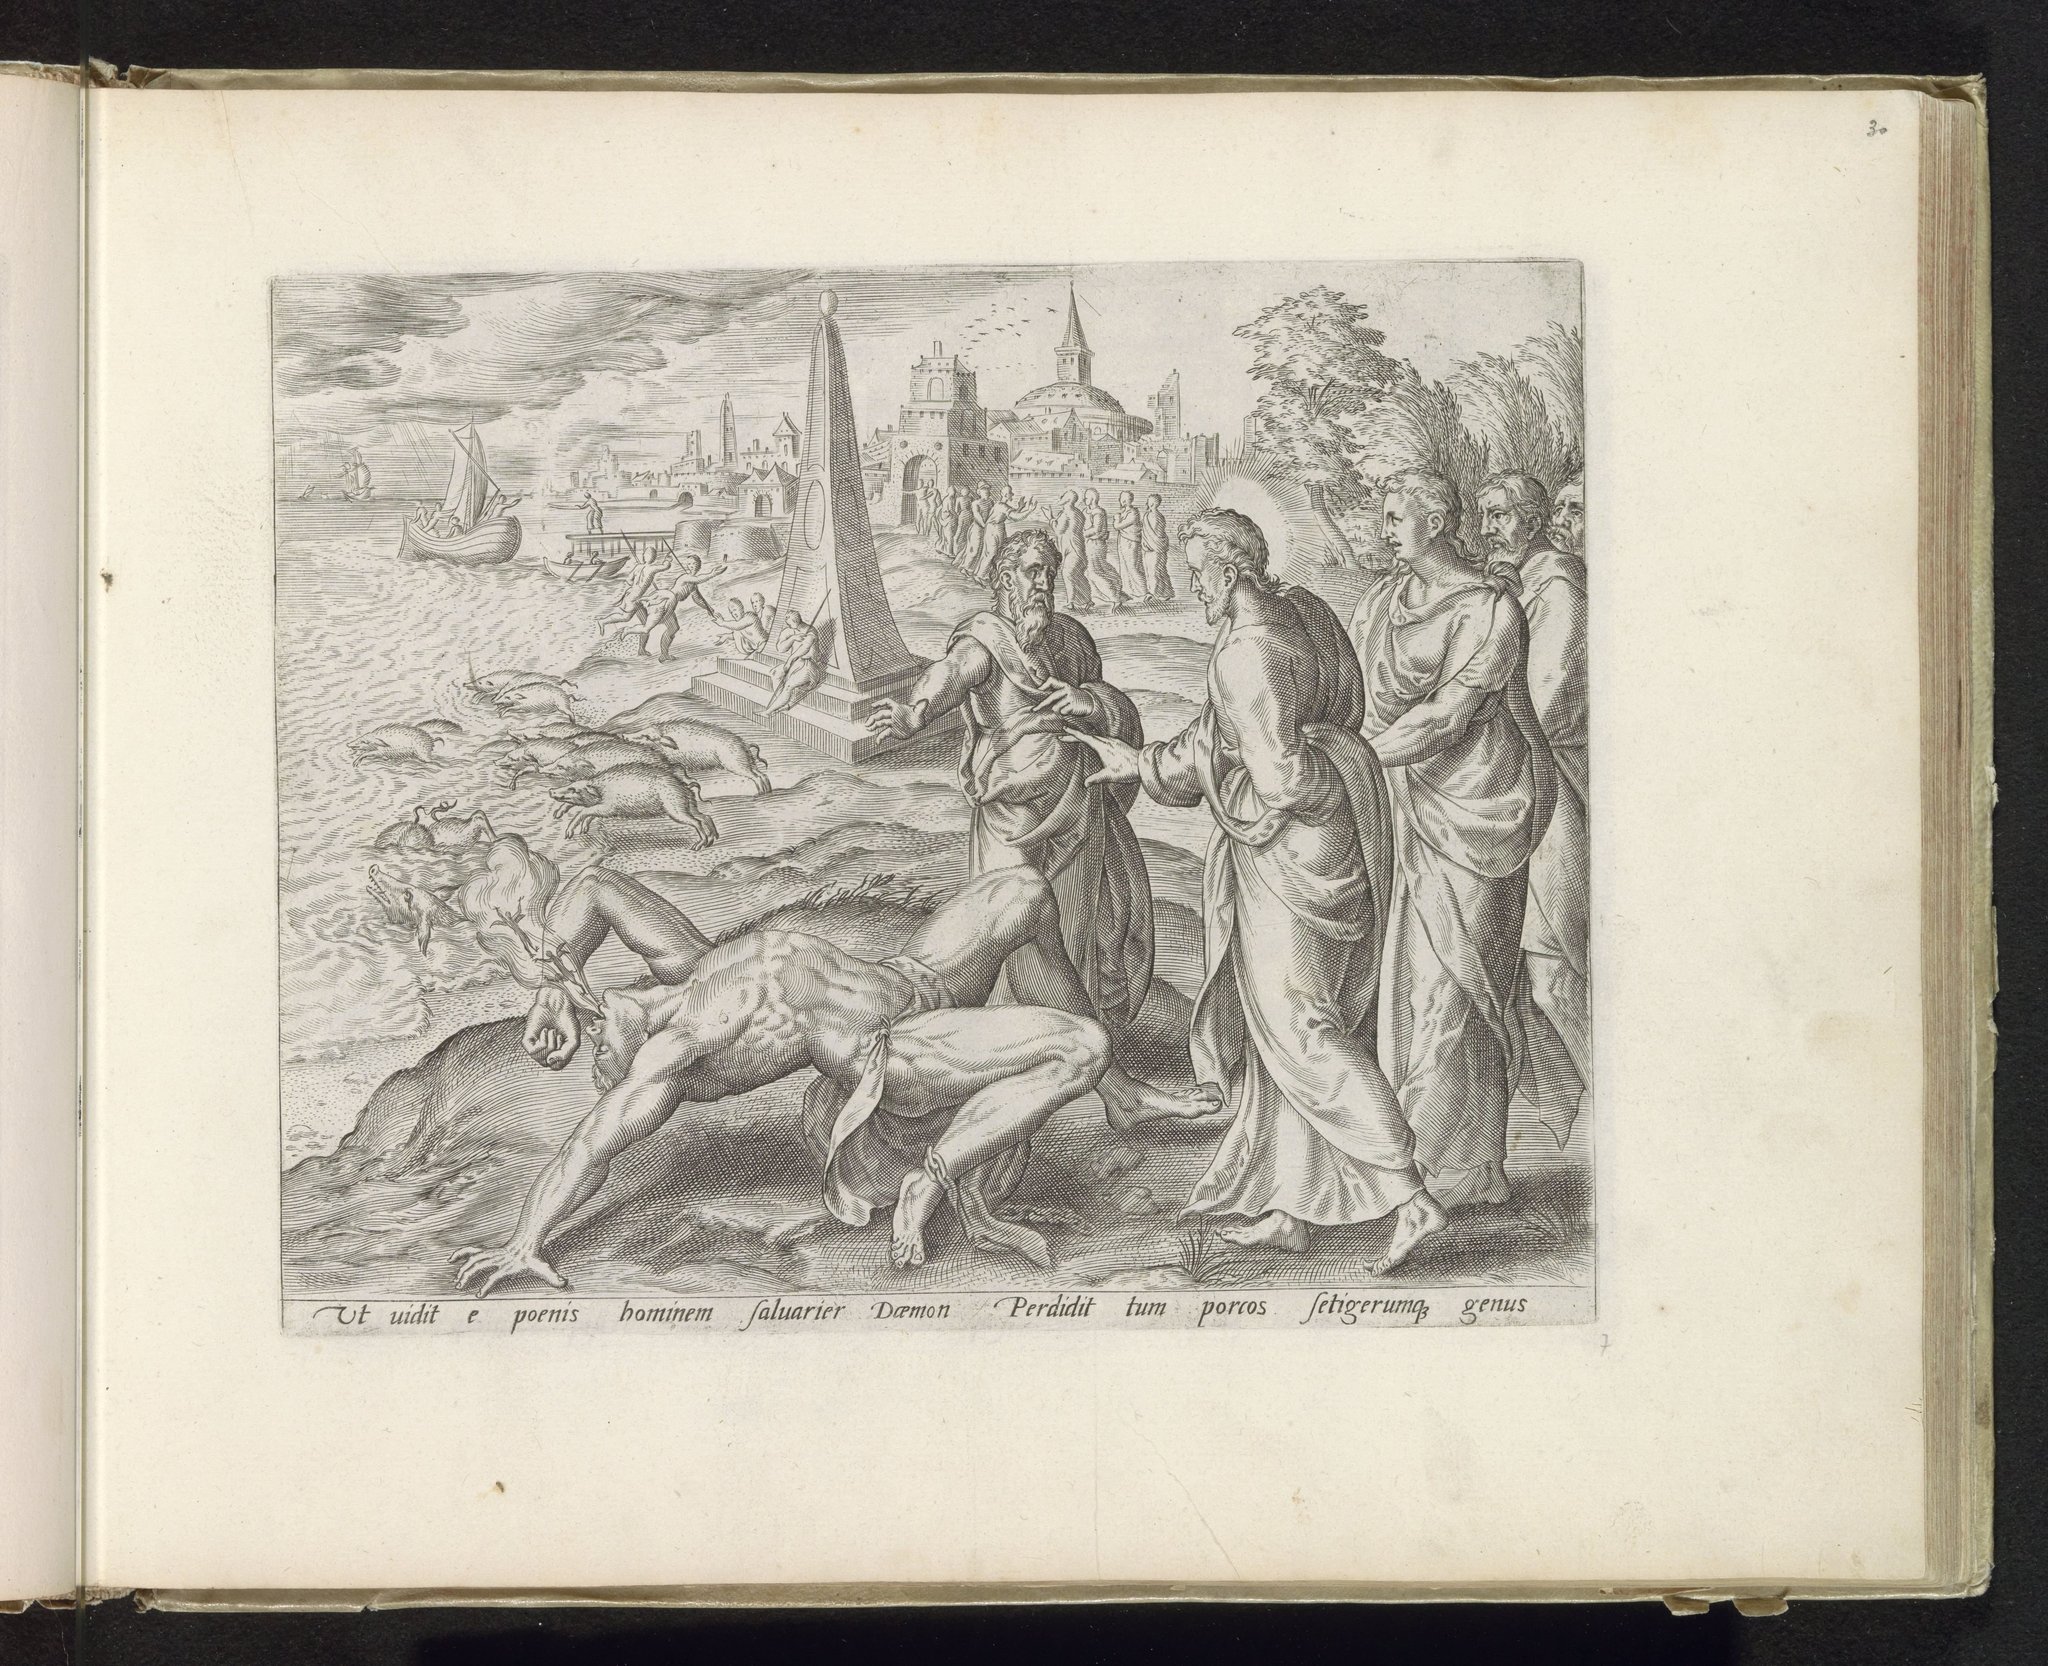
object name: print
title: Wonderen van Christus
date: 1585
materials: paper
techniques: engraving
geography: antwerp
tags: the demons enter into a herd of swine, which leap into the sea ~ healing of two possessed at gerasa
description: Christus geneest een bezeten man in het gebied van de Gerasenen. De onreine geesten verlaten de man via zijn mond en trekken in een kudde varkens, die het meer inrennen en verdrinken. De discipelen van Christus kijken toe. Op de achtergrond is het vervolg van het verhaal verbeeld: De varkenshoeders slaan op de vlucht en vertellen in de stad wat er is gebeurd. Daarop komen de bewoners naar Christus en vragen hem hun gebied te verlaten. Links op de achtergrond vertrekt Christus in een boot en blijft de genezen man achter op de steiger. Onder de voorstelling een verwijzing in het Latijn naar de Bijbeltekst in Mar. 5. Deze prent maakt deel uit van een album.